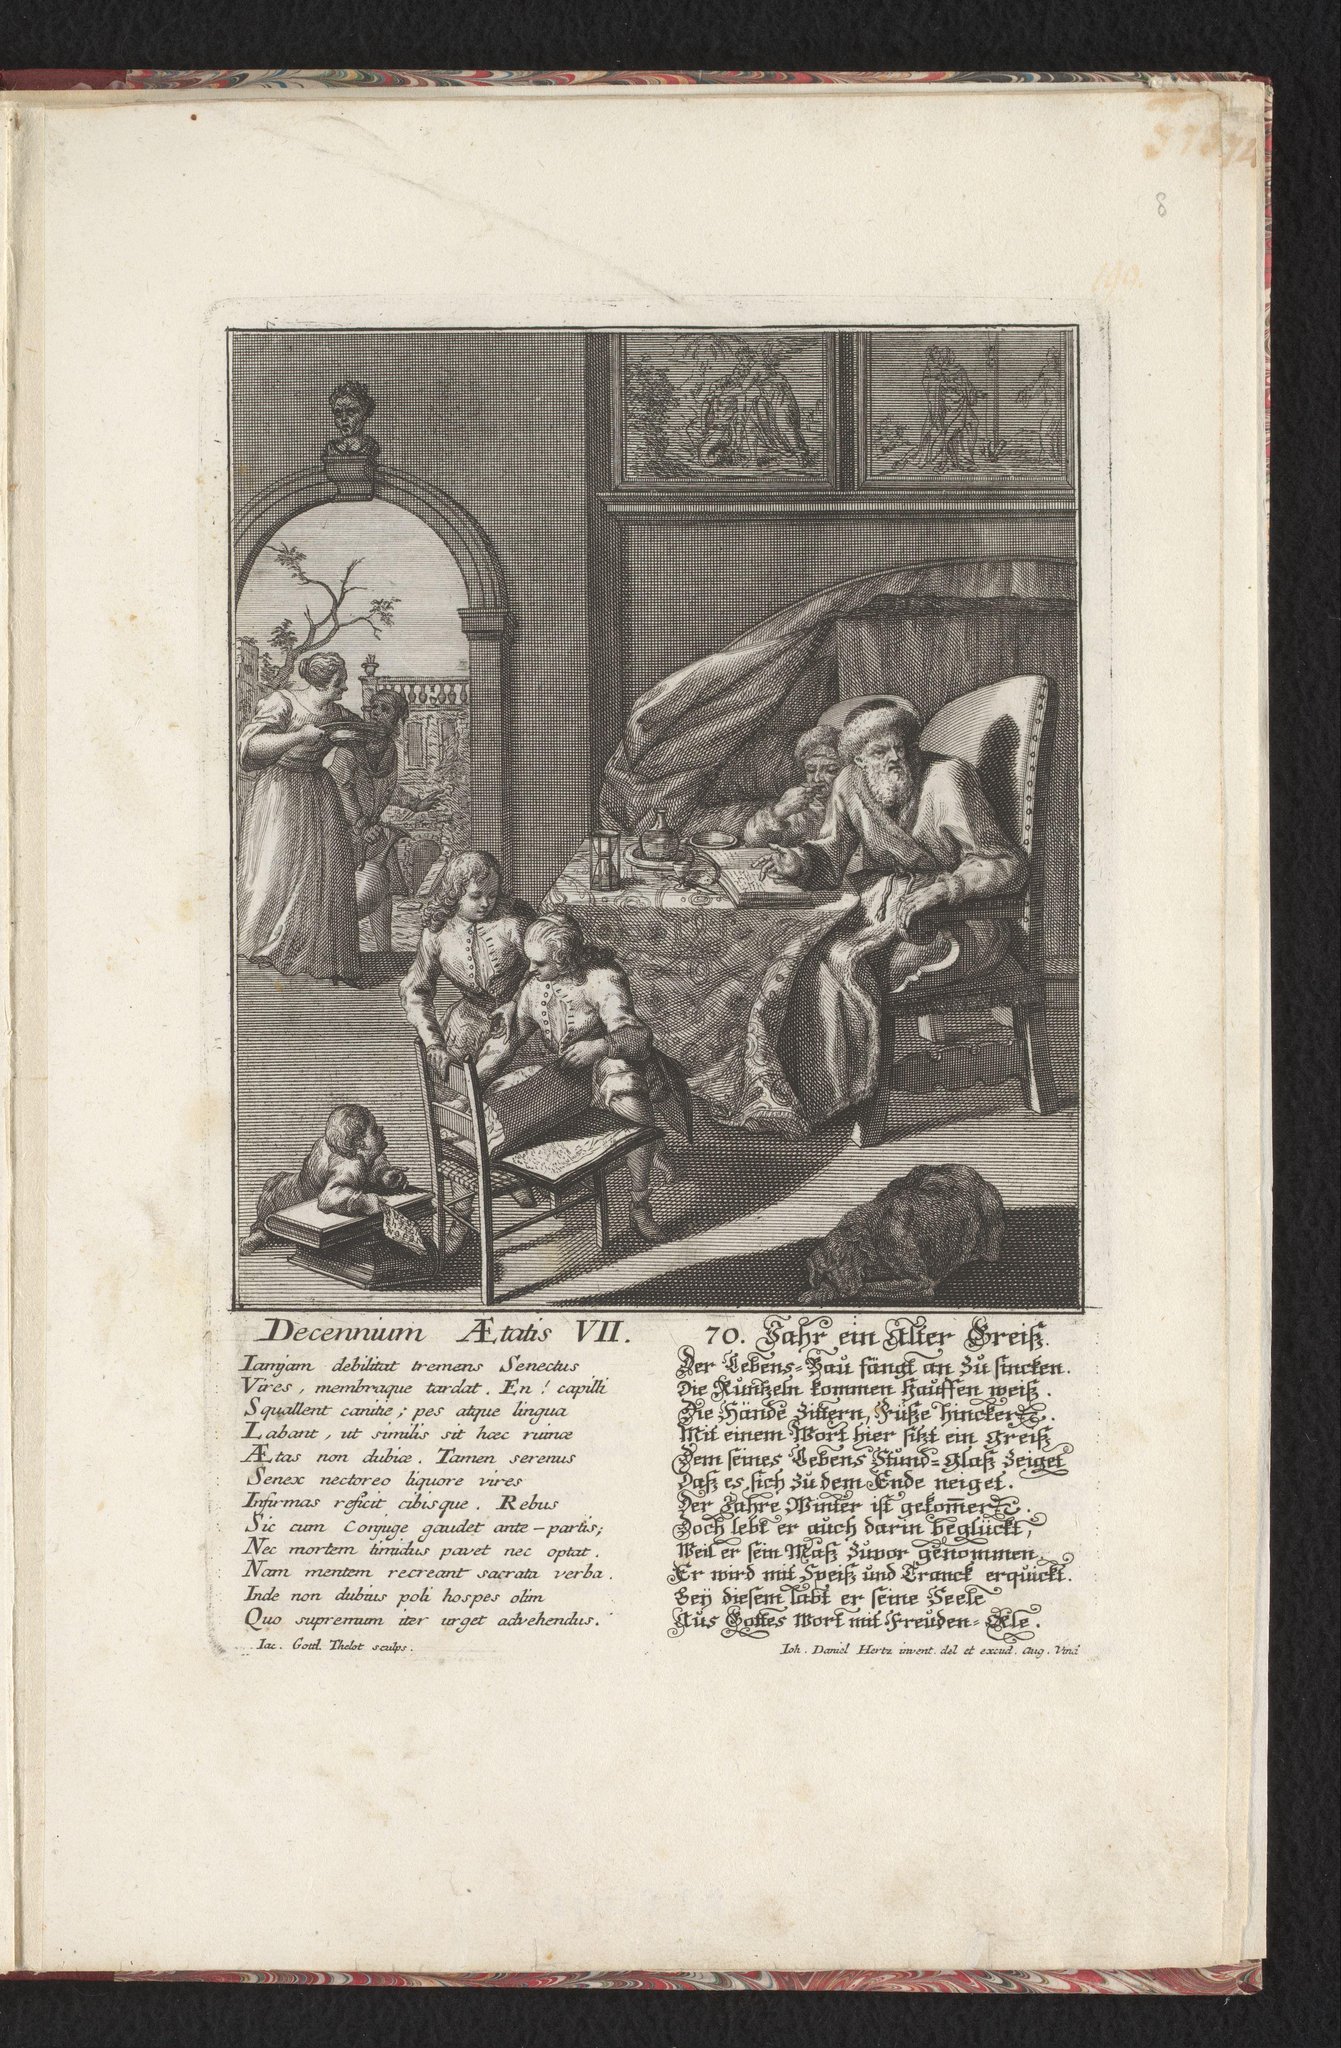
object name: album leaf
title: Decennium Aetatis VII / 70. Jahr ein Alter Greiss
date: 1725-1730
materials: paper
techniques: engraving, etching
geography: augsburg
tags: 60-70 years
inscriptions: number, watermark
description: Een oude bebaarde man in kamerjas zit in een leunstoel aan een tafel. Voor hem een boek en zandloper. Op de voorgrond kijken twee jongens in een prentenboek. Rechts een slapende hond. In de deuropening twee bedienden. Met gedichten in Latijn en Duits. Deze prent maakt deel uit van een album.